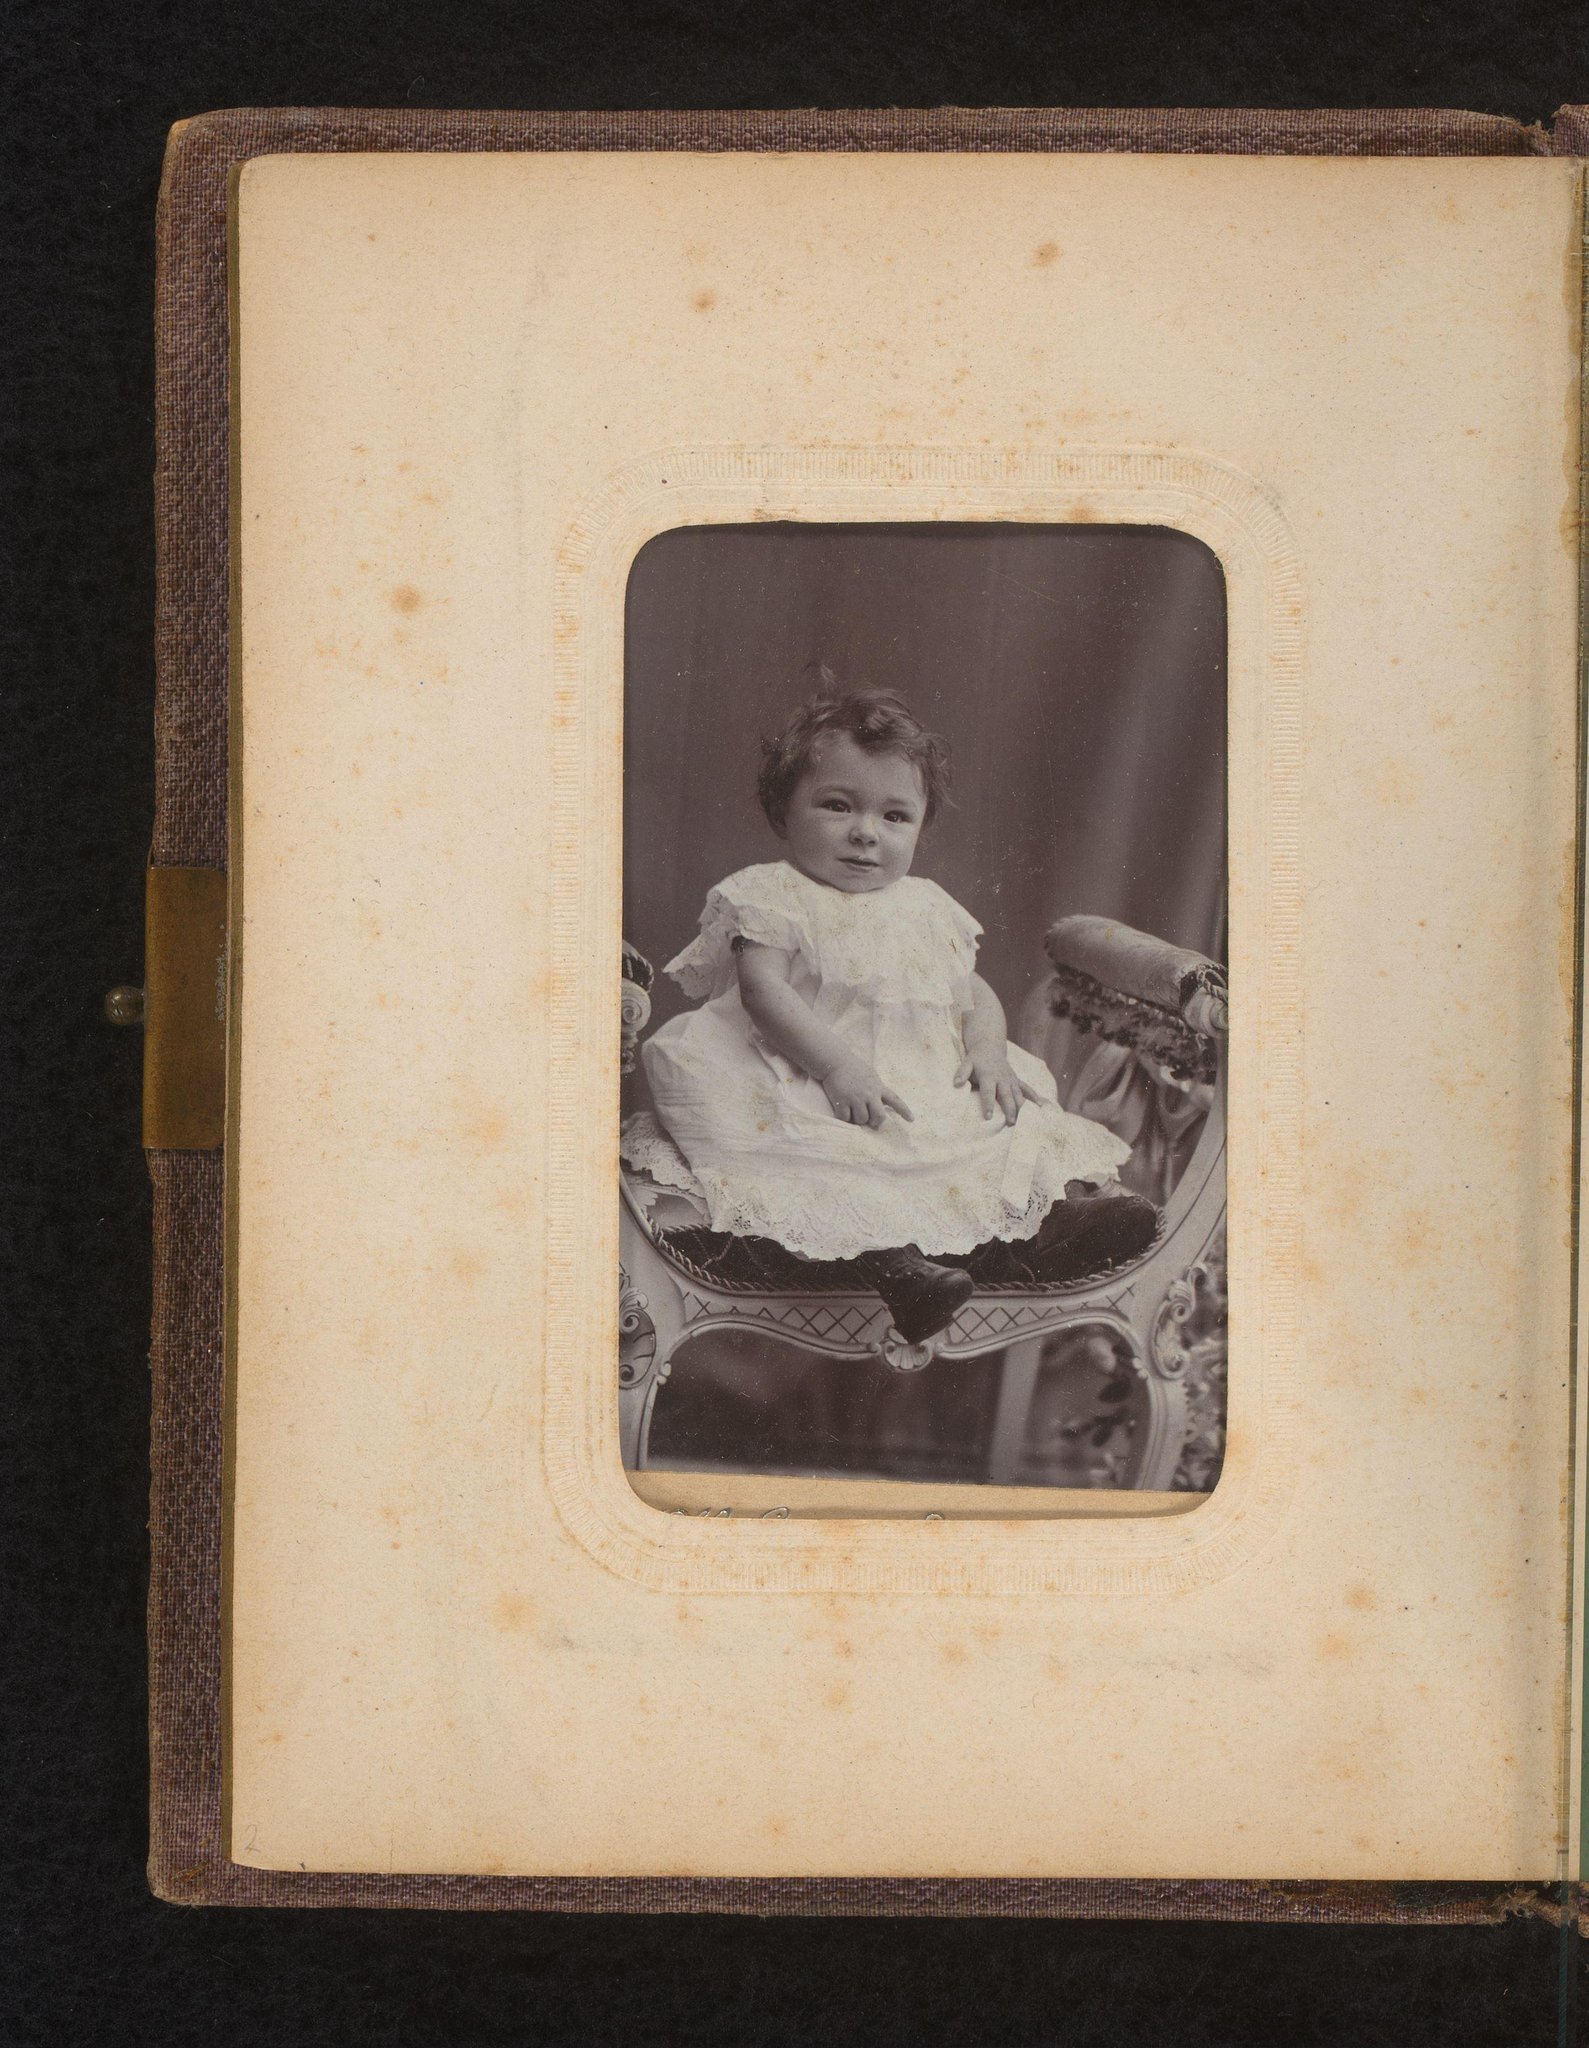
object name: photograph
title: Portret van een peuter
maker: machiel hendricus laddé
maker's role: fotograaf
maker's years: 1866-1932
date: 1880-1906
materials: cardboard, photographic support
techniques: collodion silver print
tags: toddler, historical persons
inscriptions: inscription: ‘Photographie Artistique/ M. H Laddé/ (...)/ Amsterdam/ 57-59/ Nieuwenijk’